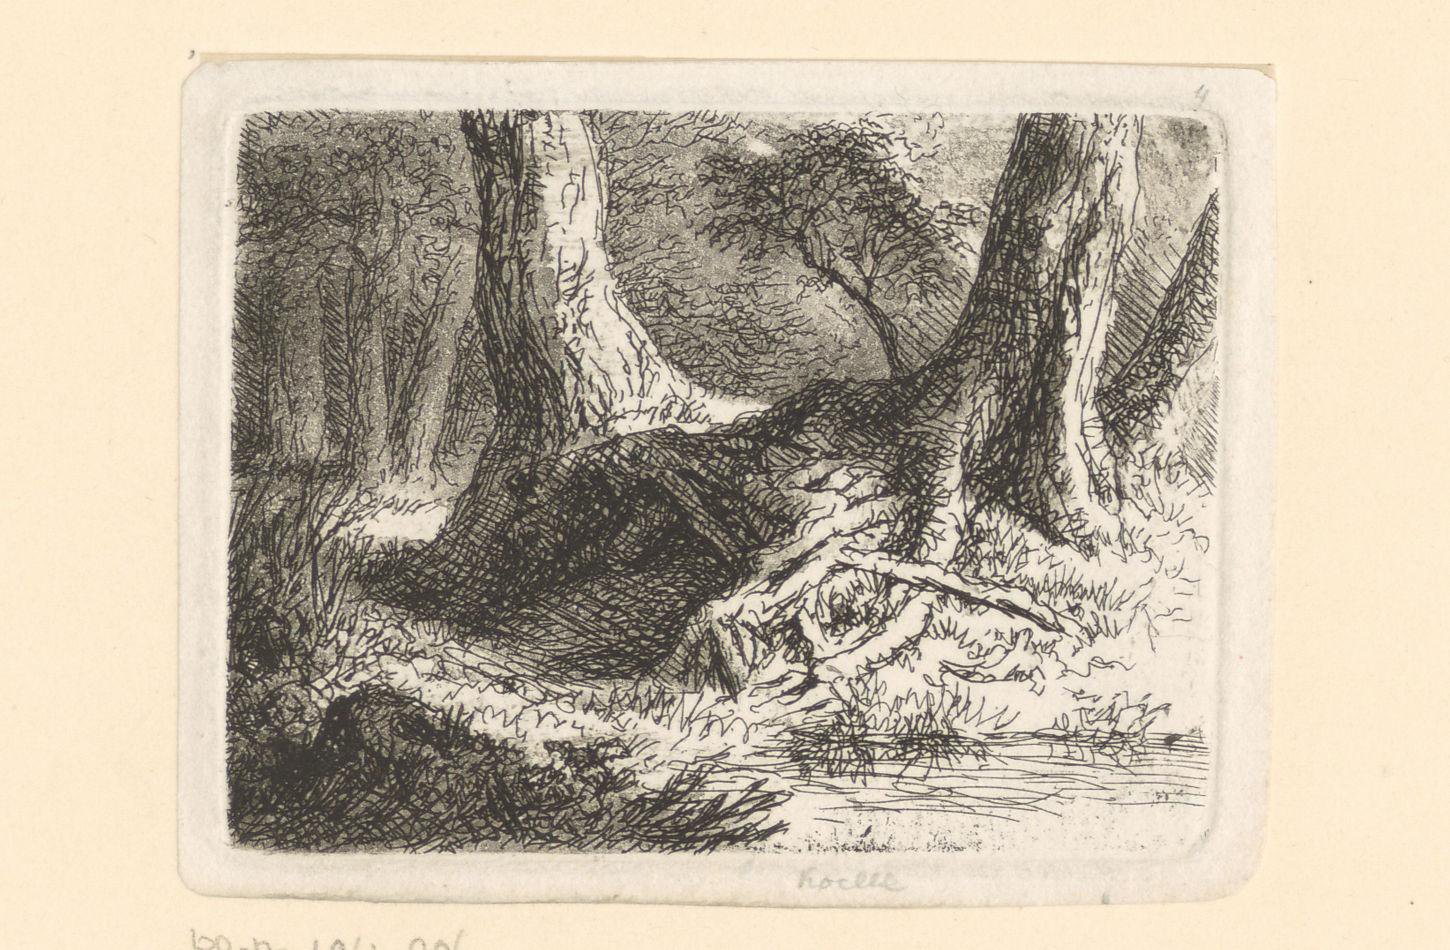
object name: print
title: Landschap met boomwortels bij een beek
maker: ferdinand kobell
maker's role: artist, painter, print maker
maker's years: 1740-1799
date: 1750-1799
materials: paper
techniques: aquatint, etching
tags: trees, forest, wood, brook